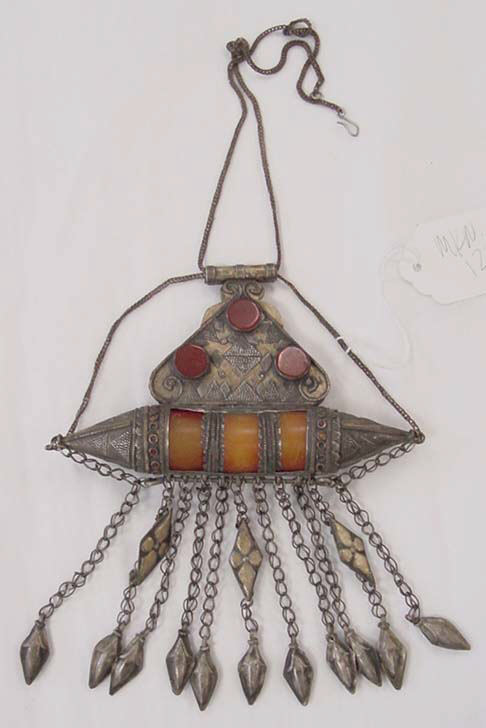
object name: necklace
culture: moroccan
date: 1801-1900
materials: amber, gemstone, metal